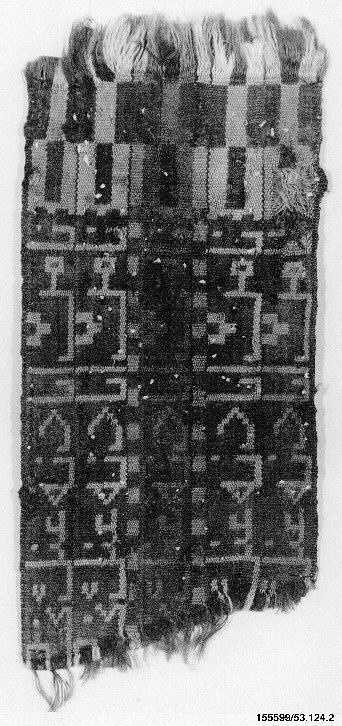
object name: band fragment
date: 1001-1200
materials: wool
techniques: weave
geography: egypt